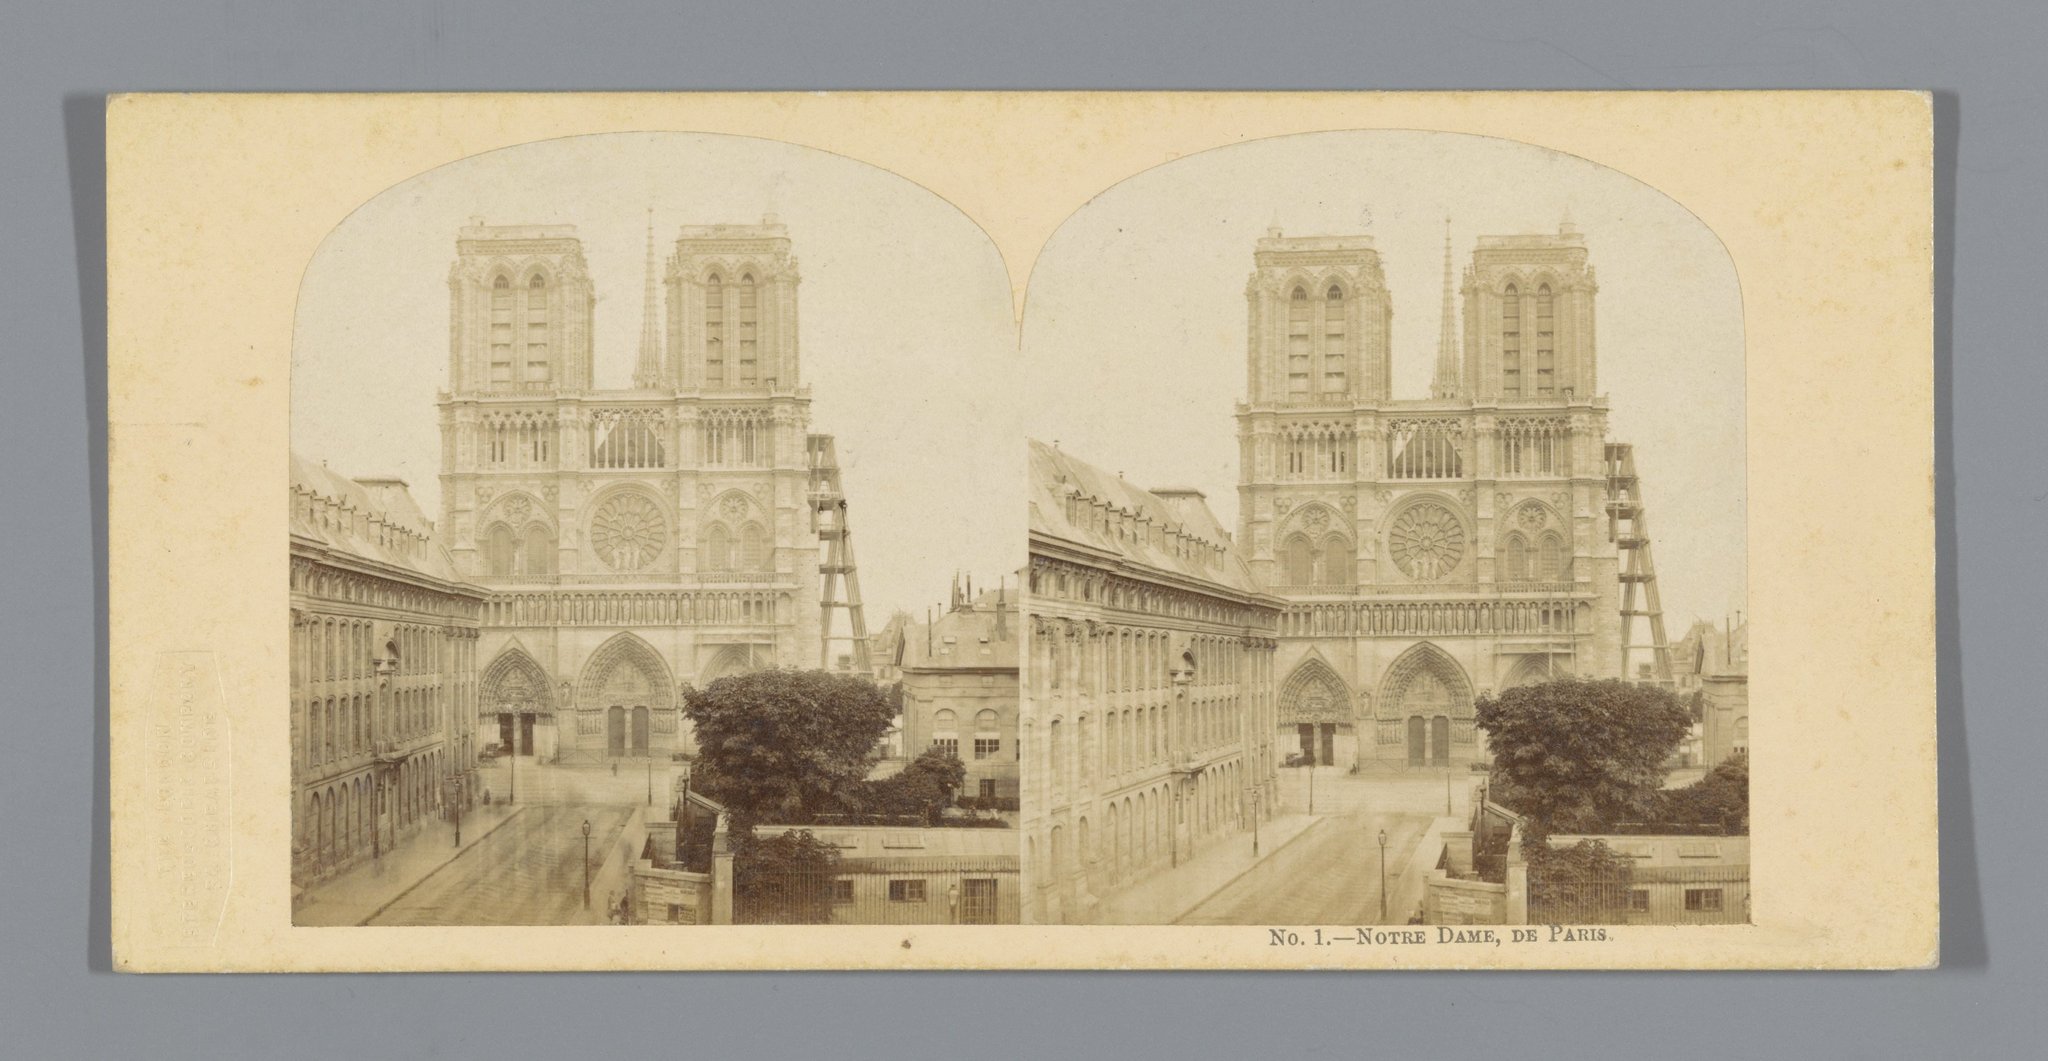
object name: stereograph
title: Notre Dame, de Paris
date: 1850-1875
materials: cardboard, photographic support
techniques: albumen print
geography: paris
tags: church (exterior)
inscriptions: number: ‘No. 1.’